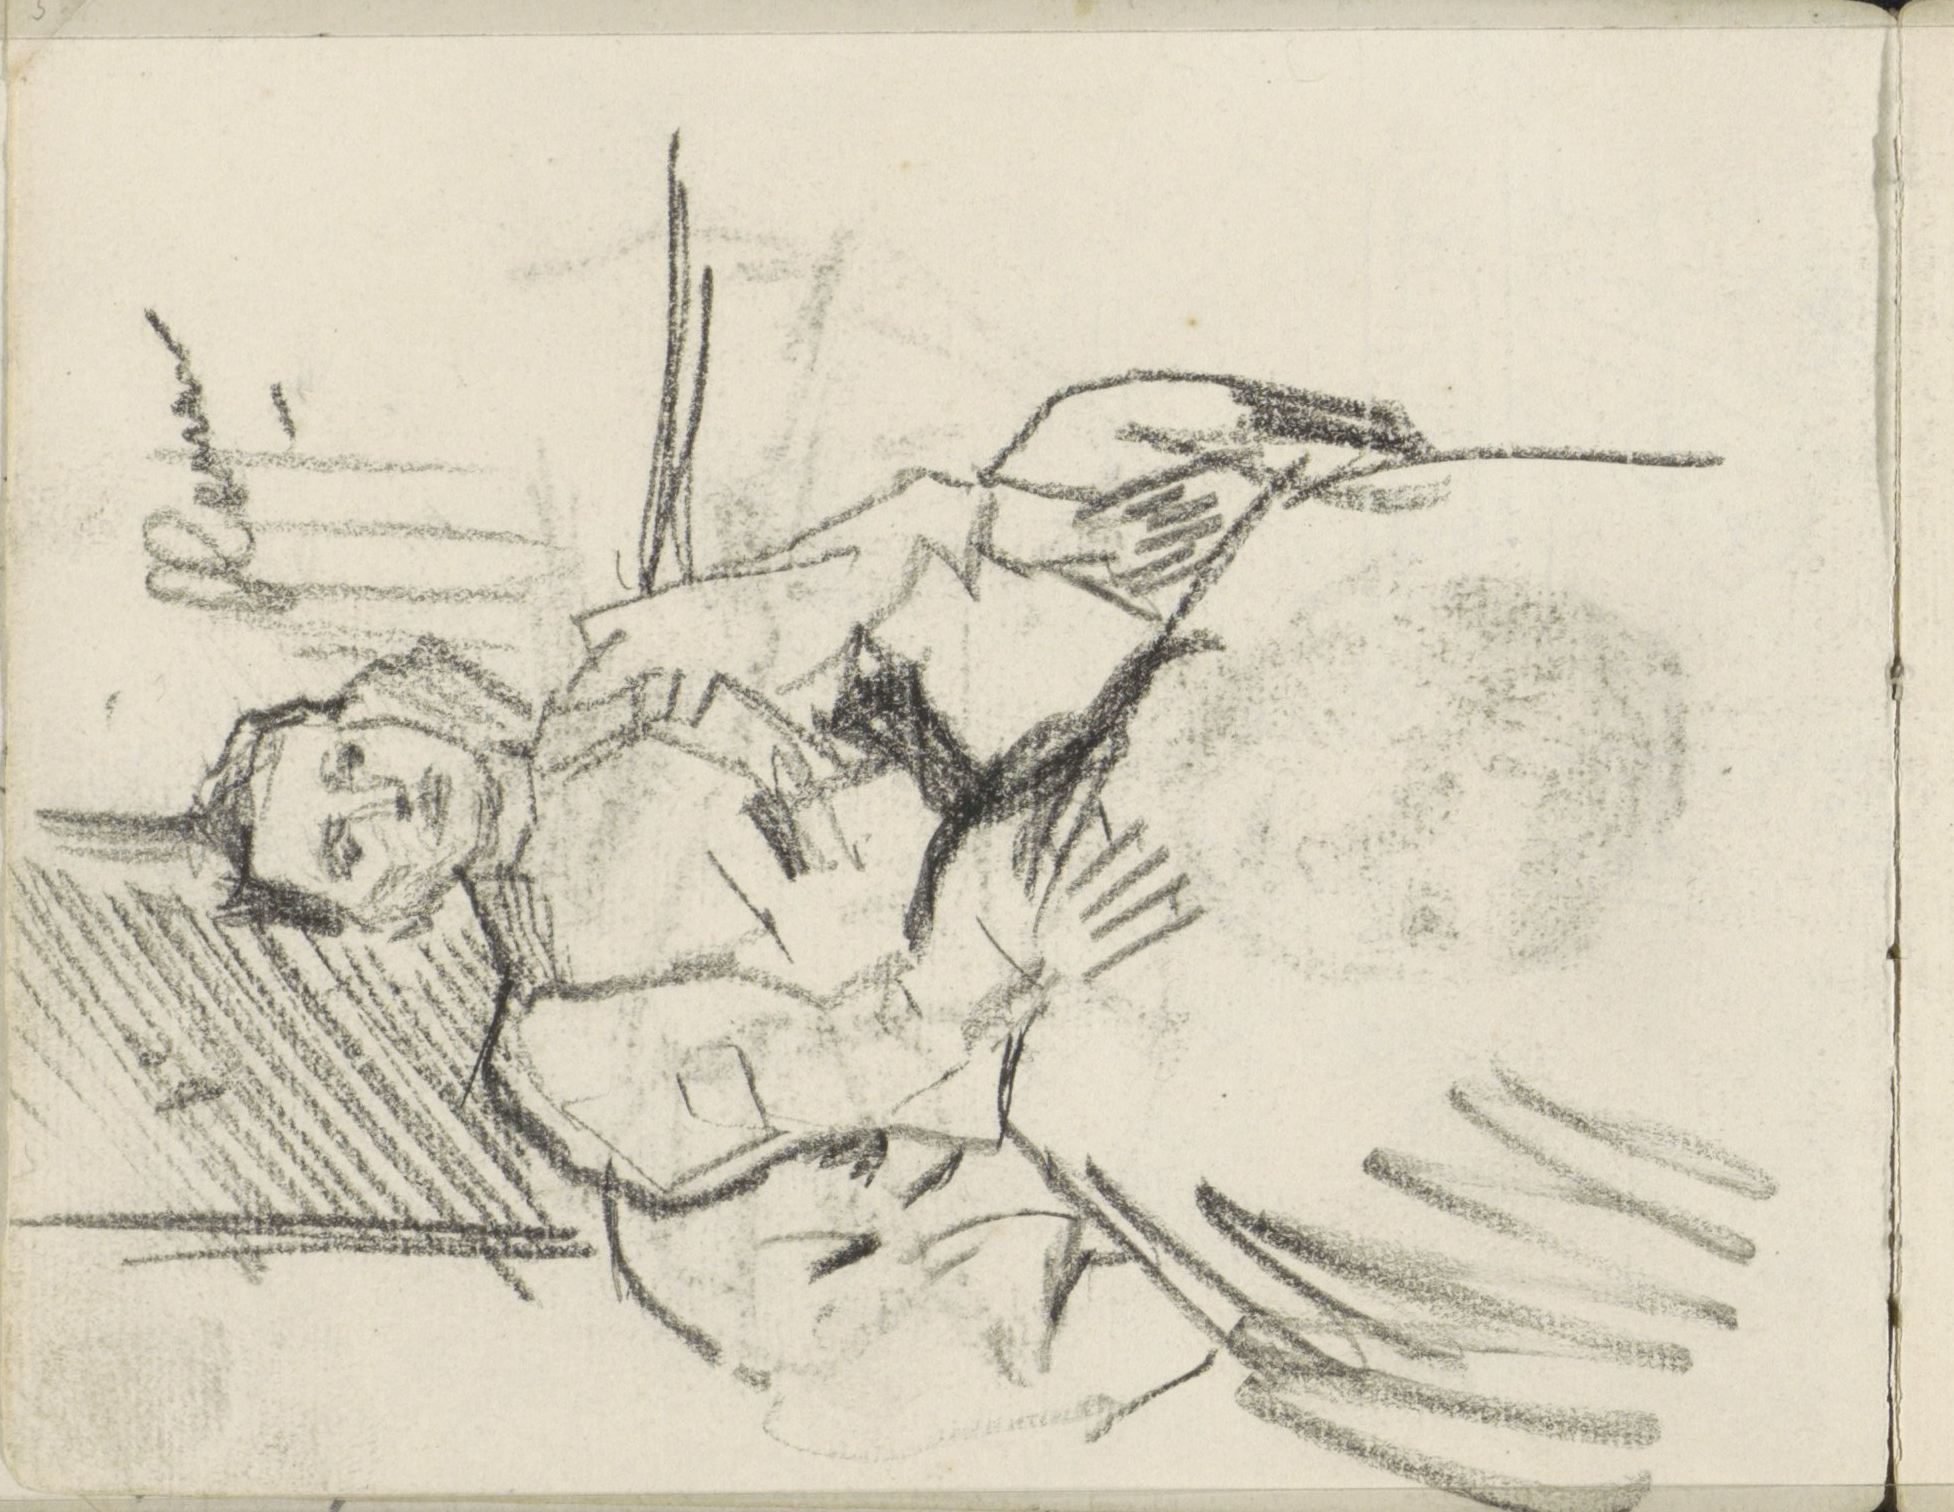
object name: sketchbook leaf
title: Zittende vrouw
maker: george hendrik breitner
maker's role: draughtsman, painter, print maker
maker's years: 1857-1923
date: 1893-1899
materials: chalk, paper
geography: amsterdam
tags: adult woman, sitting figure - aa - female human figure, anonymous historical person portrayed - bb - woman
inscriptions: kleurnotitie, handgeschreven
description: Pagina 3 uit een schetsboek met 28 bladen.